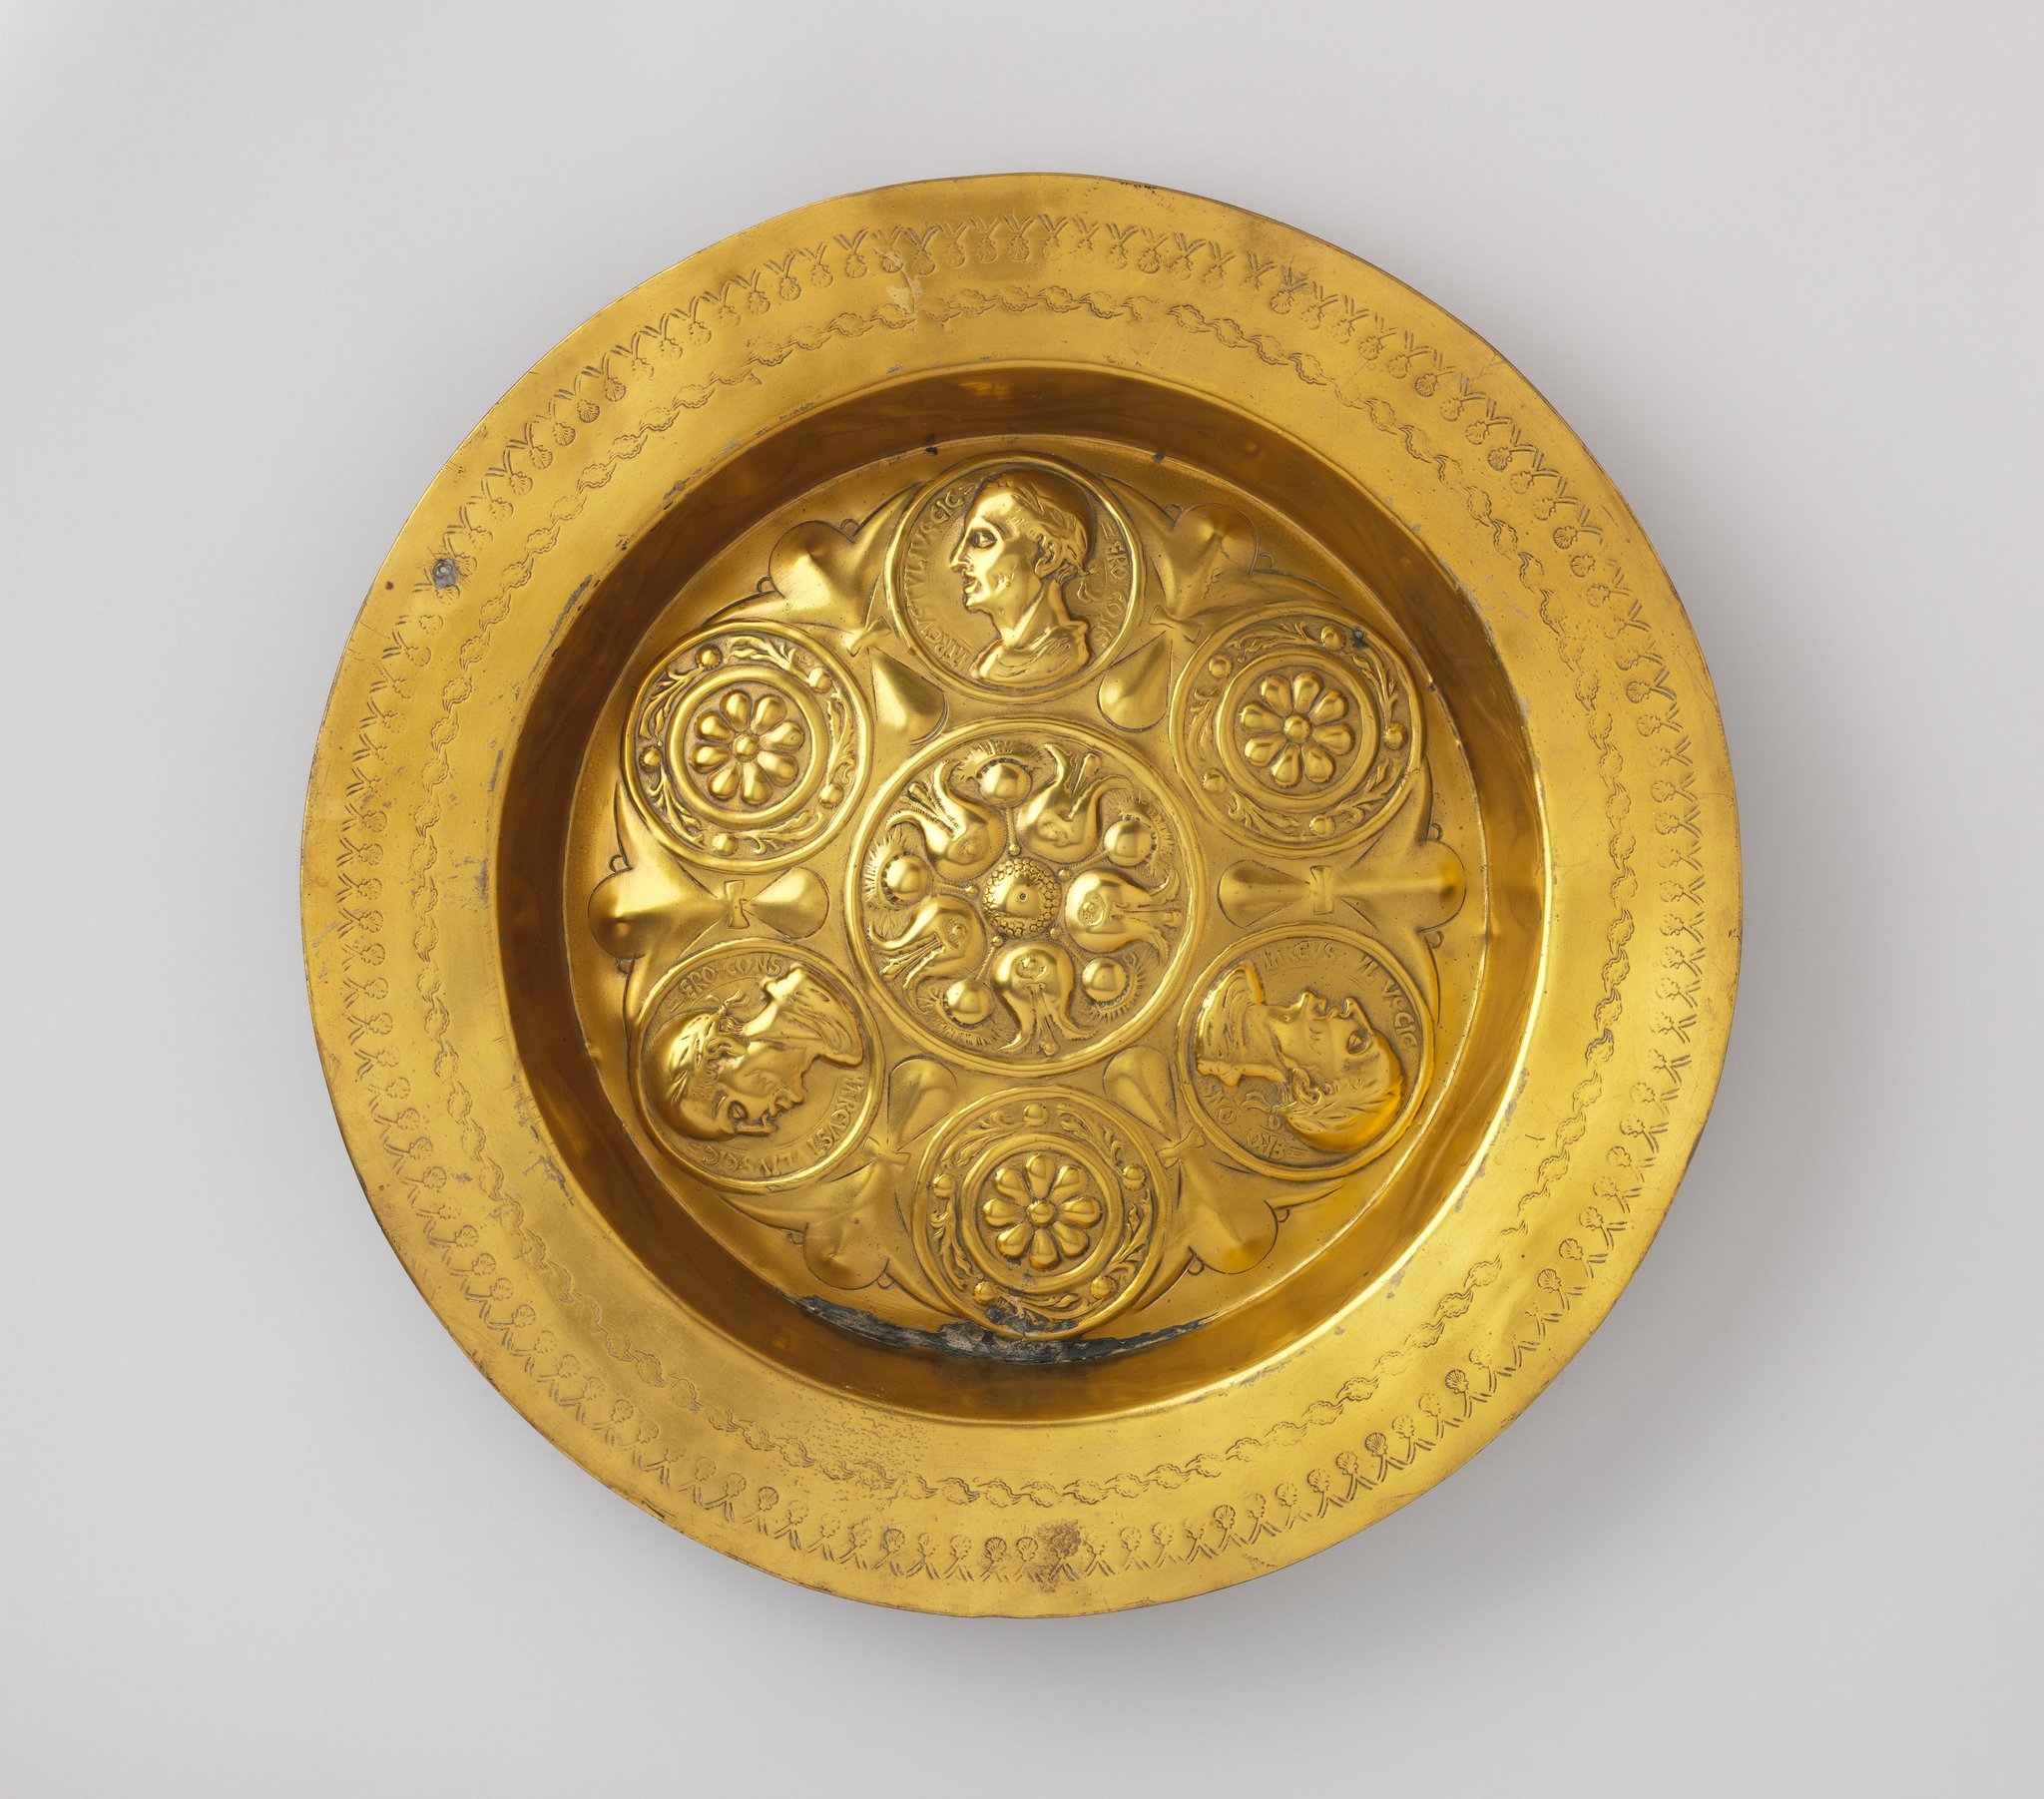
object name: basin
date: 1501-1550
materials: brass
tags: men